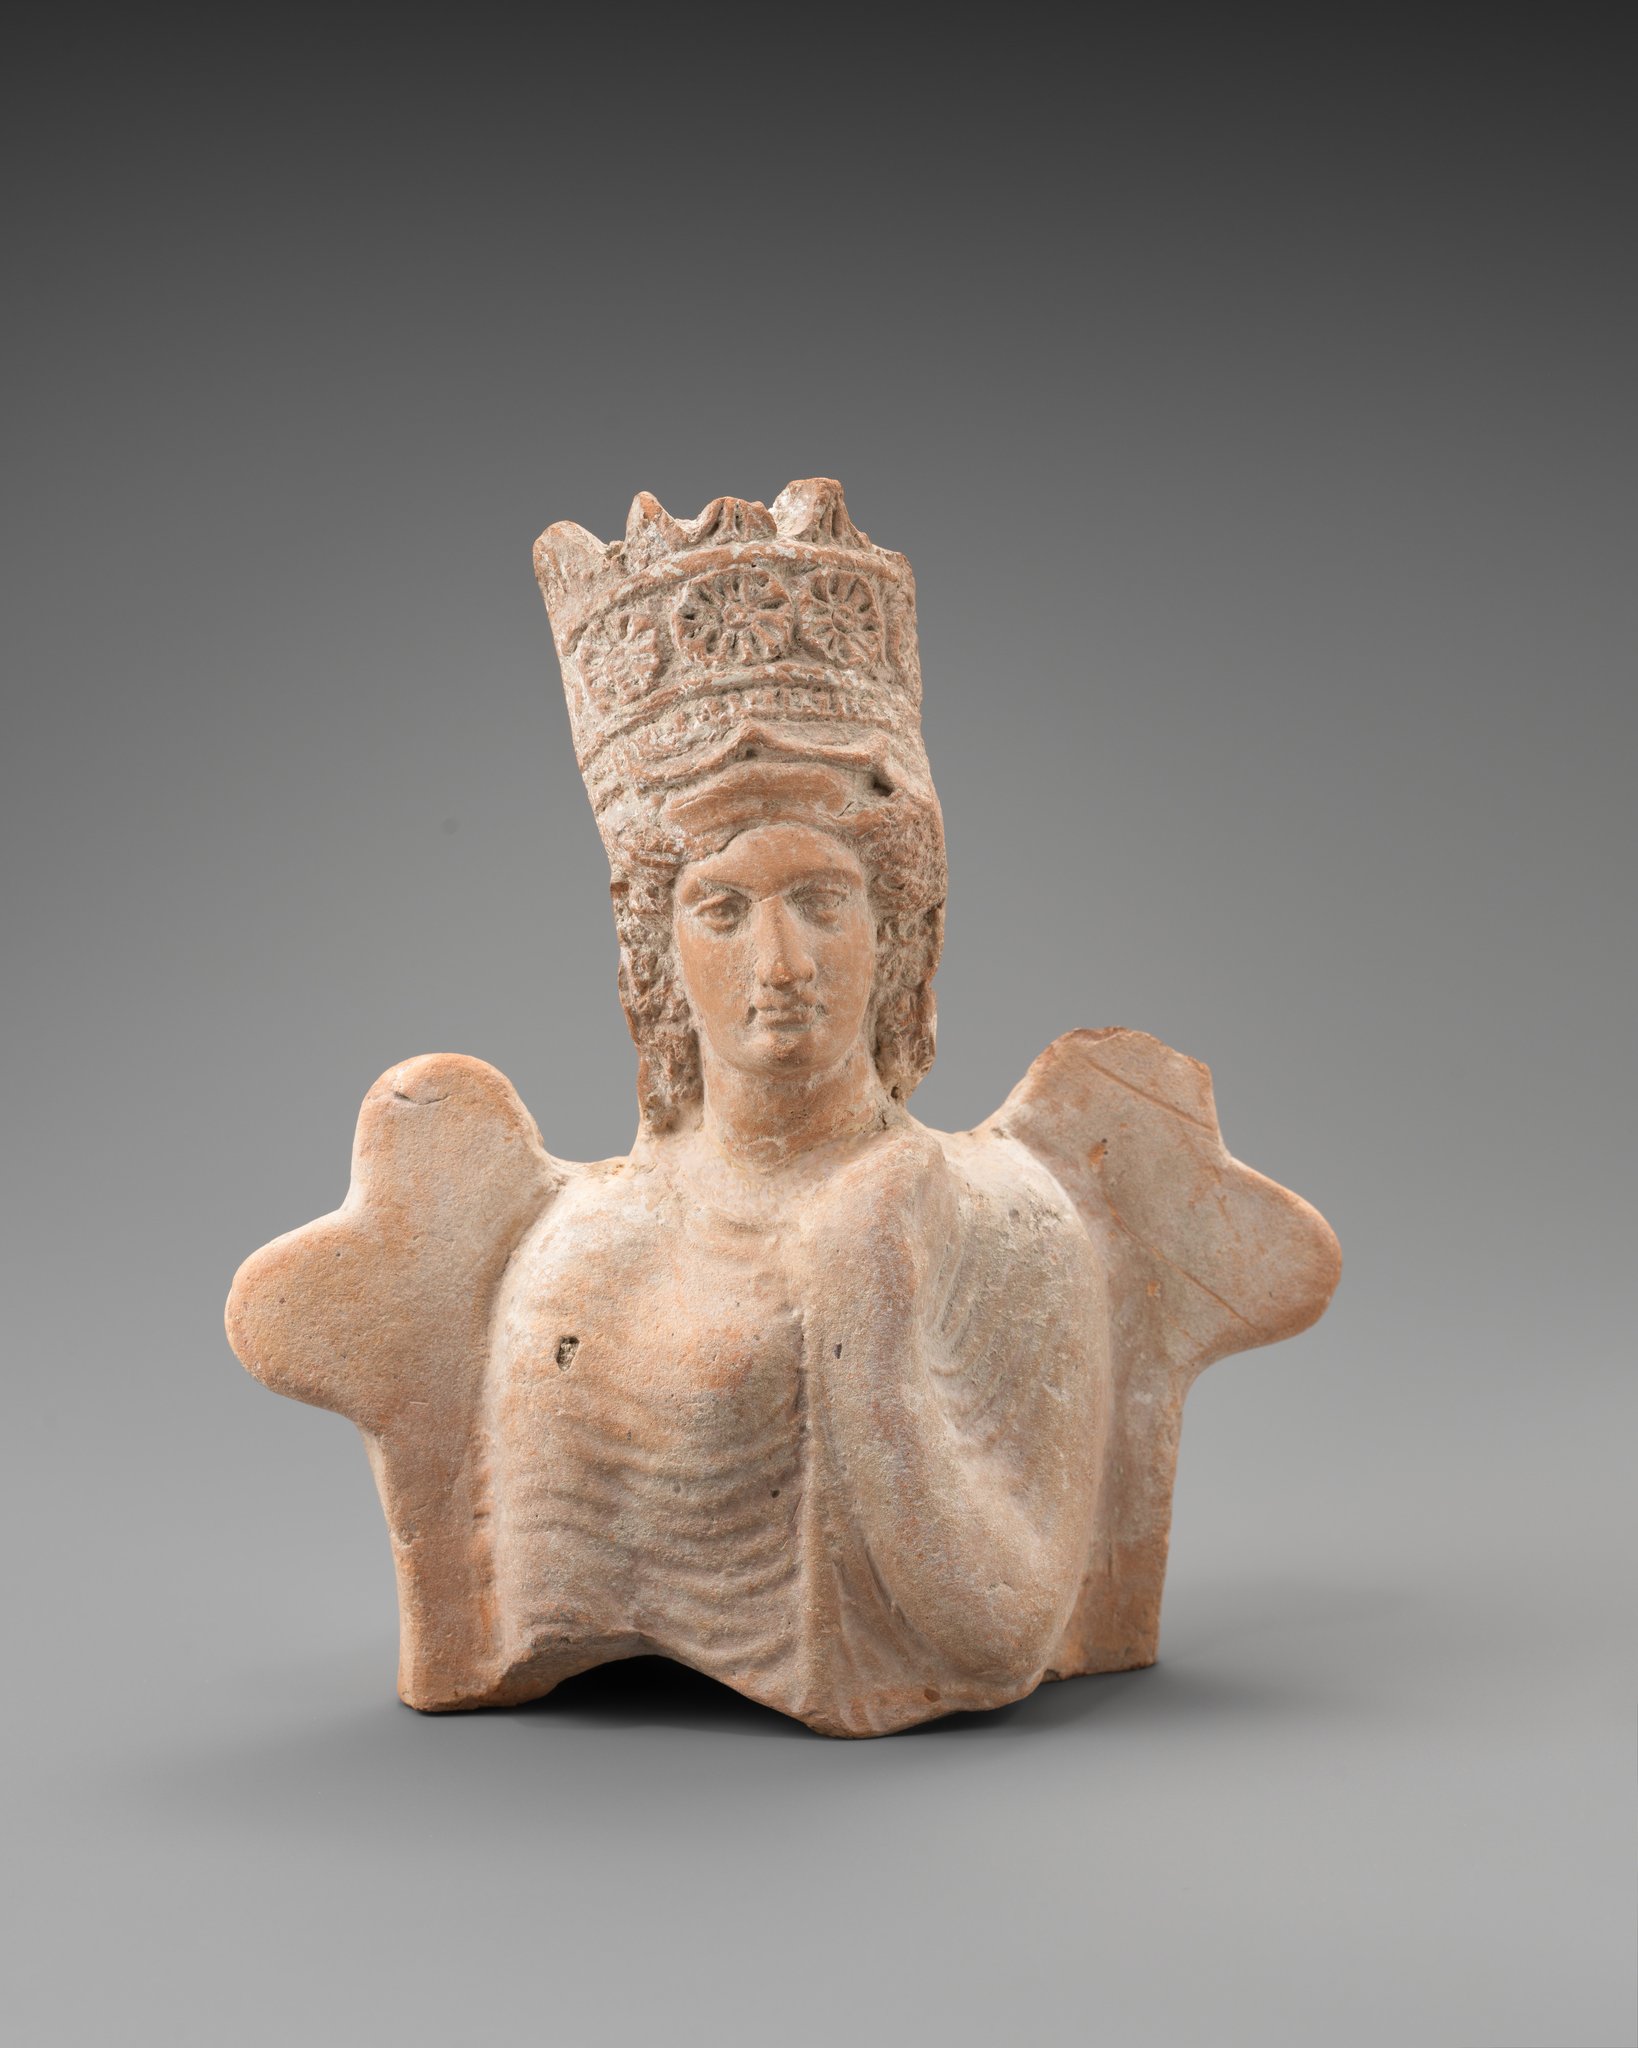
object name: statuette of a seated goddess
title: Seated goddess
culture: cypriot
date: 400-301 BCE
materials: terracotta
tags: goddess